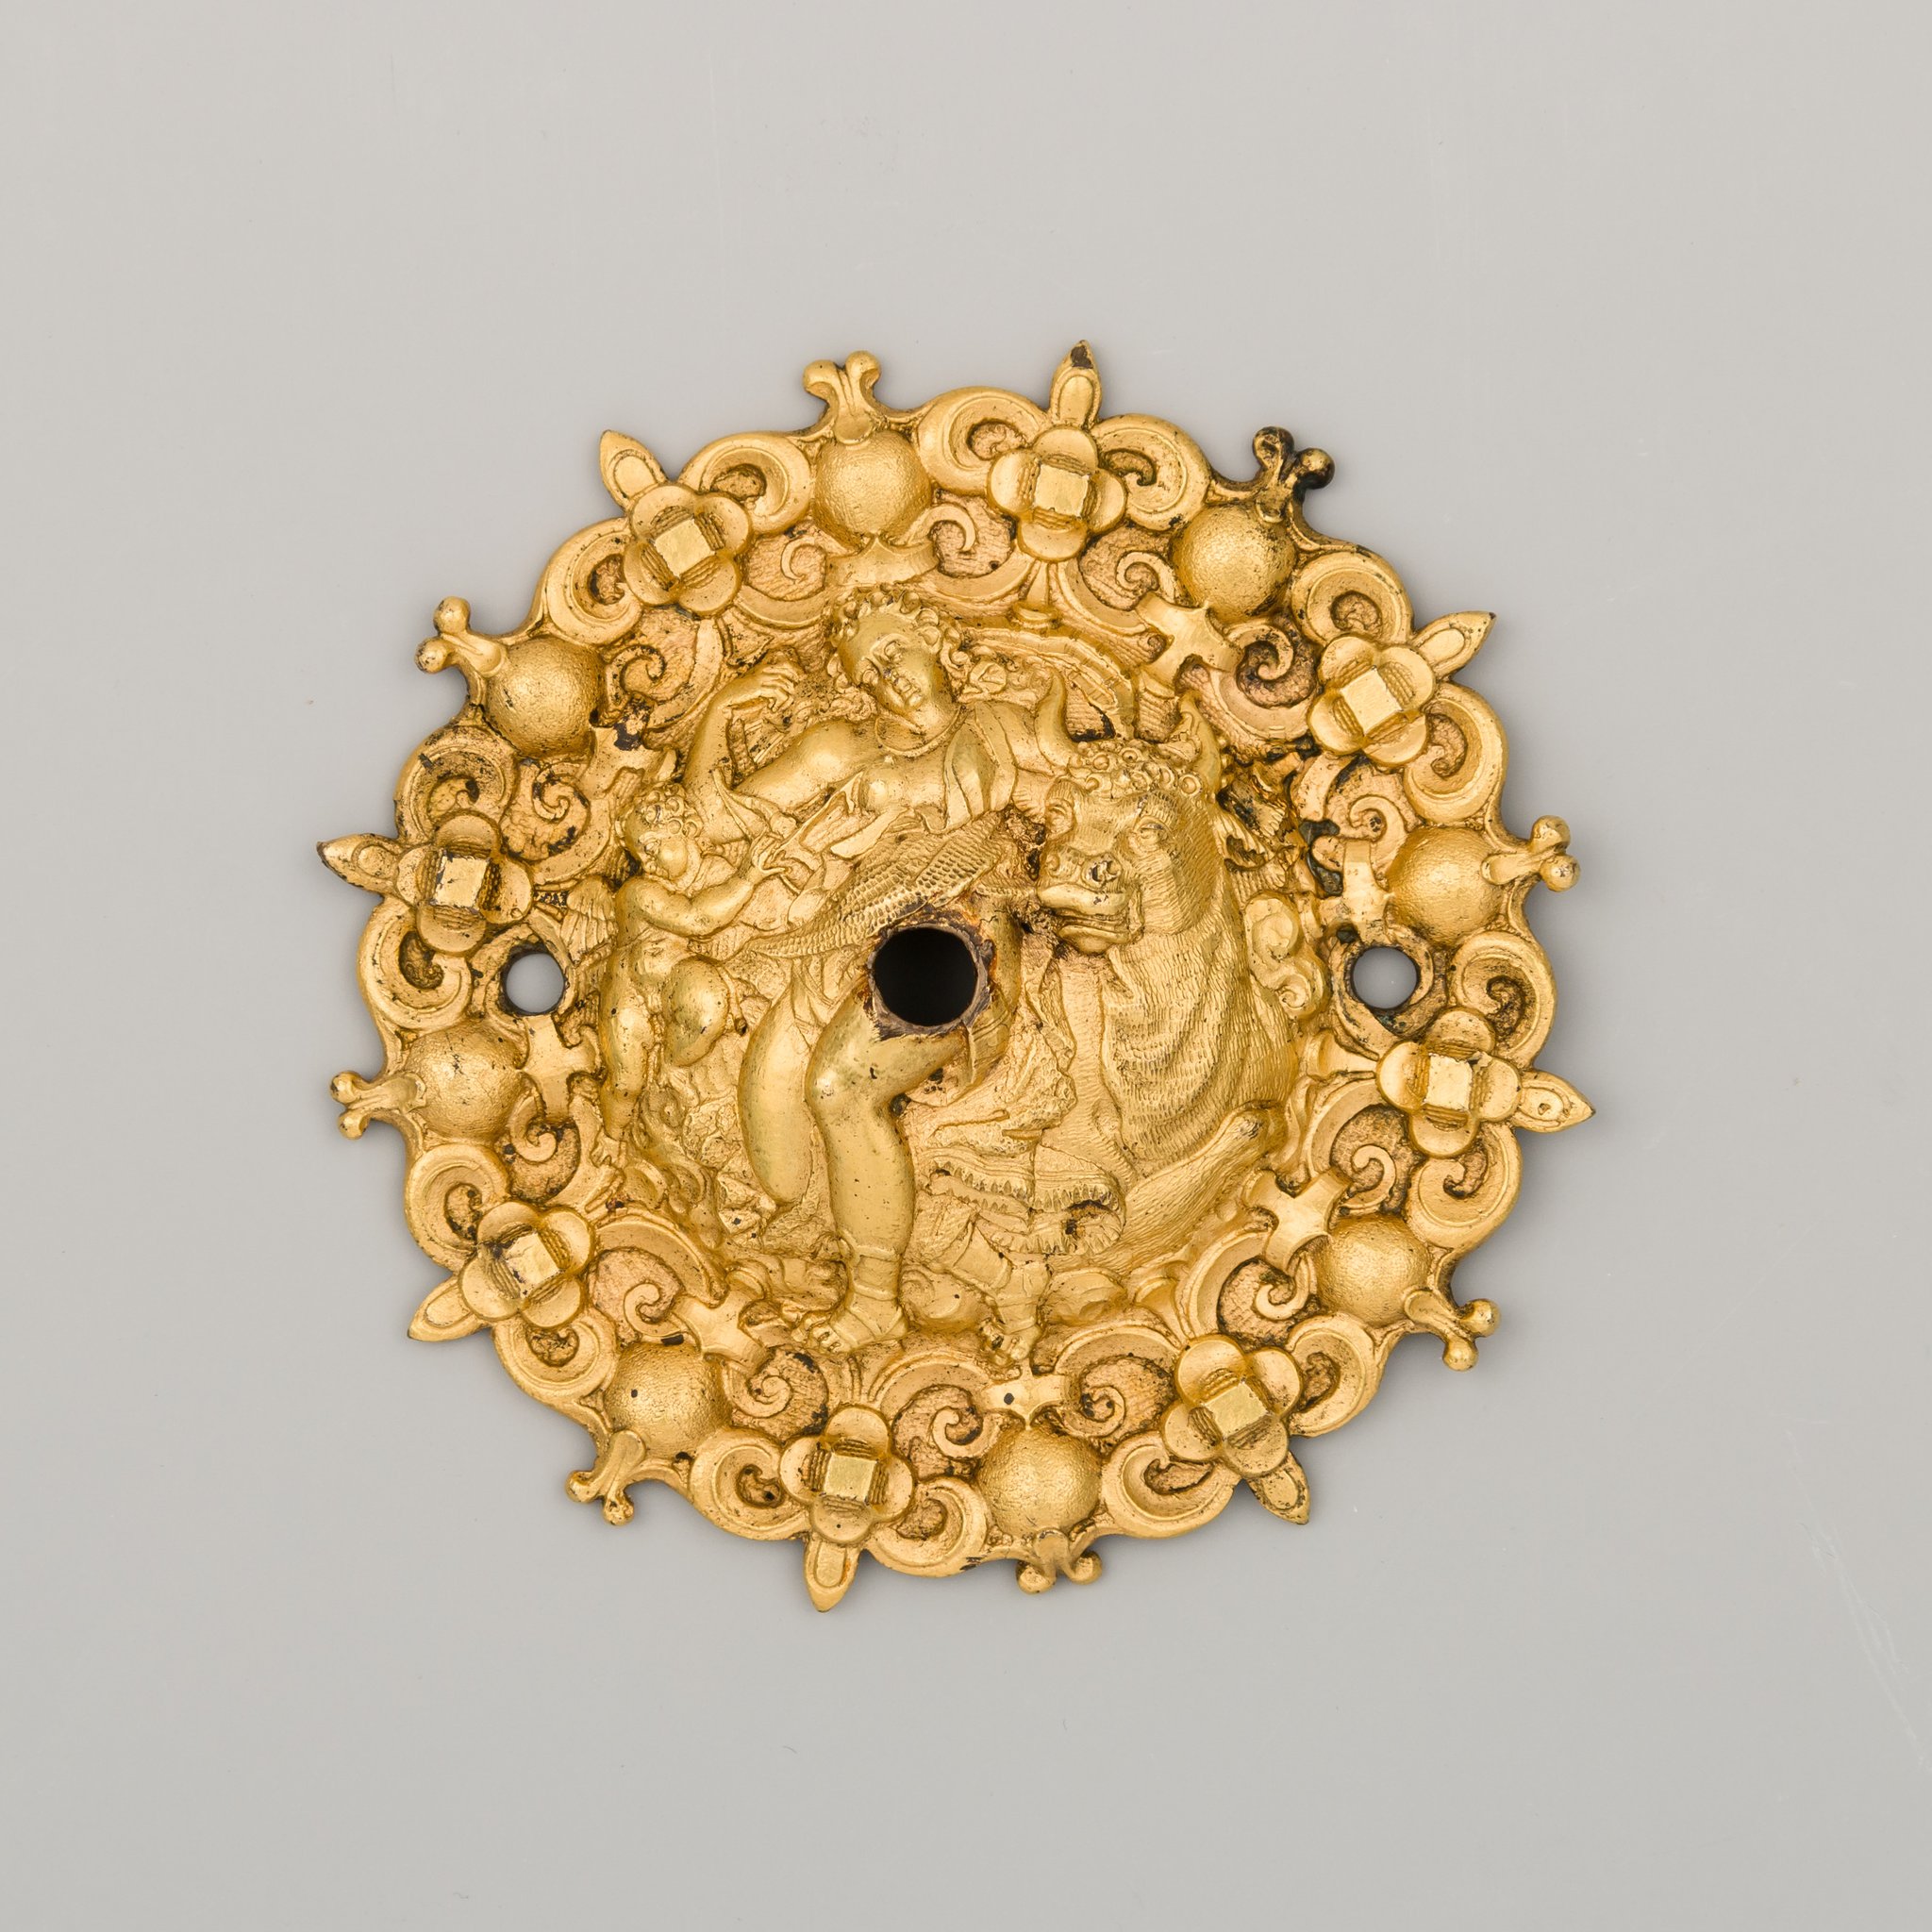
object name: bit bos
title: Bit Boss with the Rape of Europa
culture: dutch or german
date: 1601-1650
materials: copper alloy, gold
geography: netherlands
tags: human figures,animals